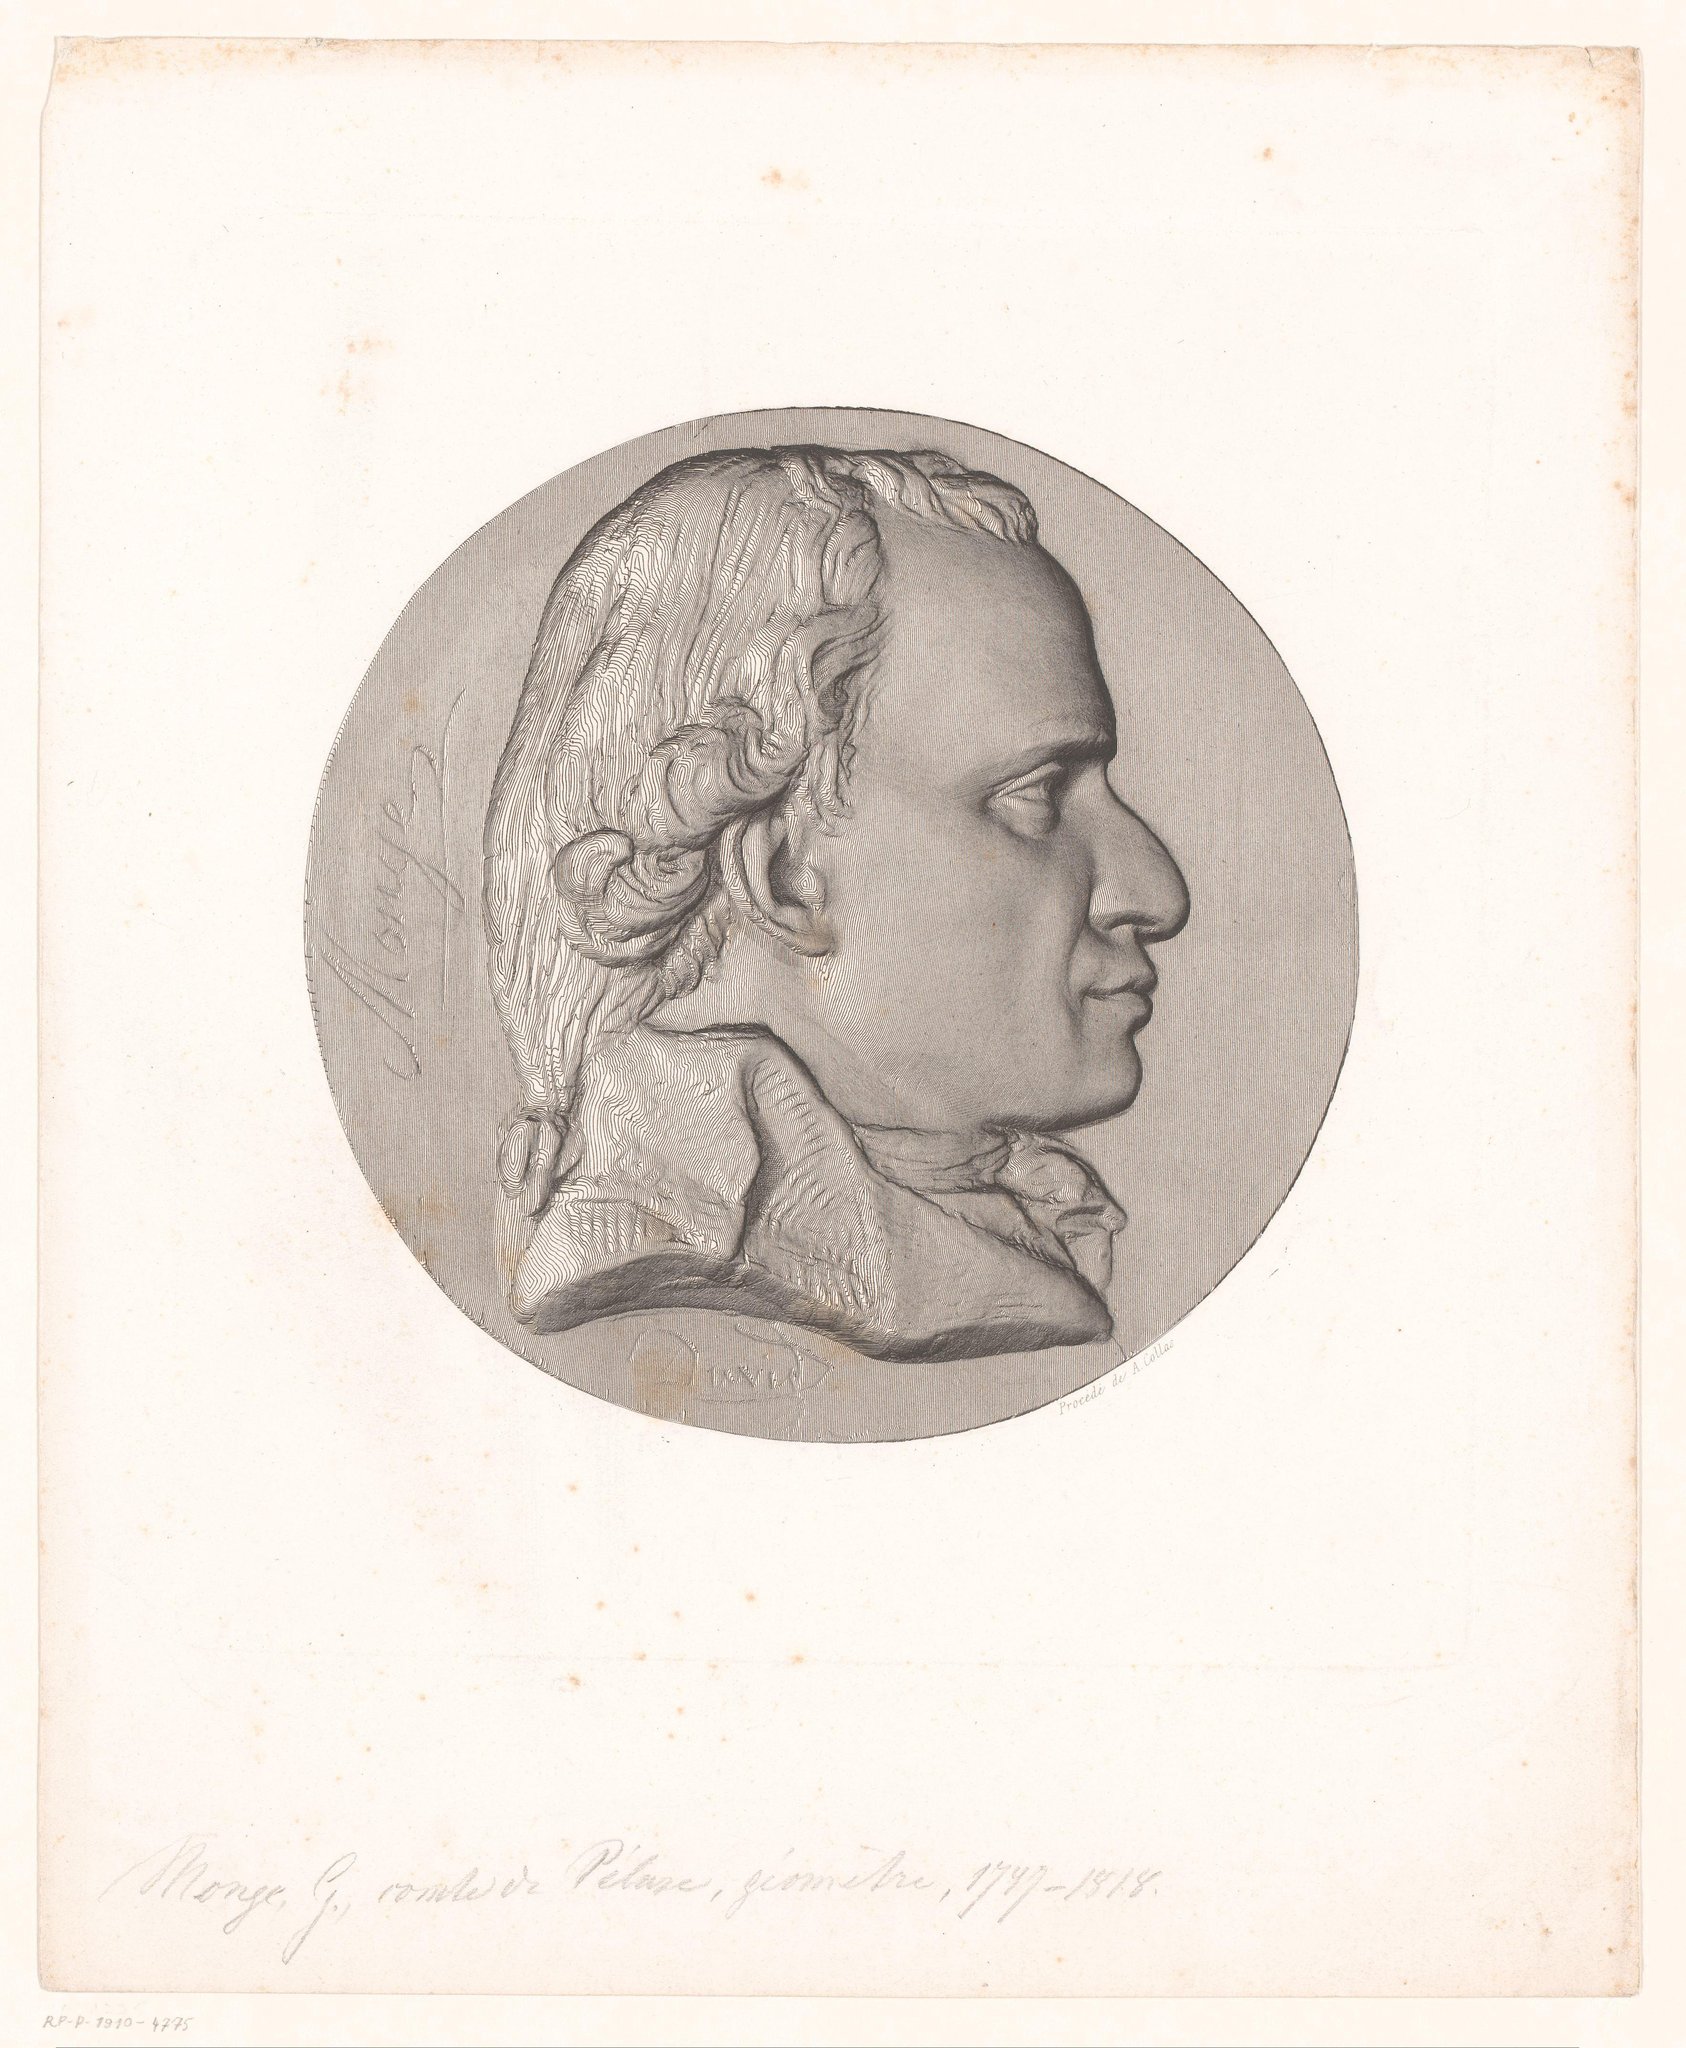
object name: print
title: Serie medaillons met vooraanstaande figuren uit het begin van de negentiende eeuw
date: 1820-1840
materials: paper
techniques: relief engraving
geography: france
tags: paris, ornament ~ medallion, historical persons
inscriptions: collector's mark: Lugt 2228